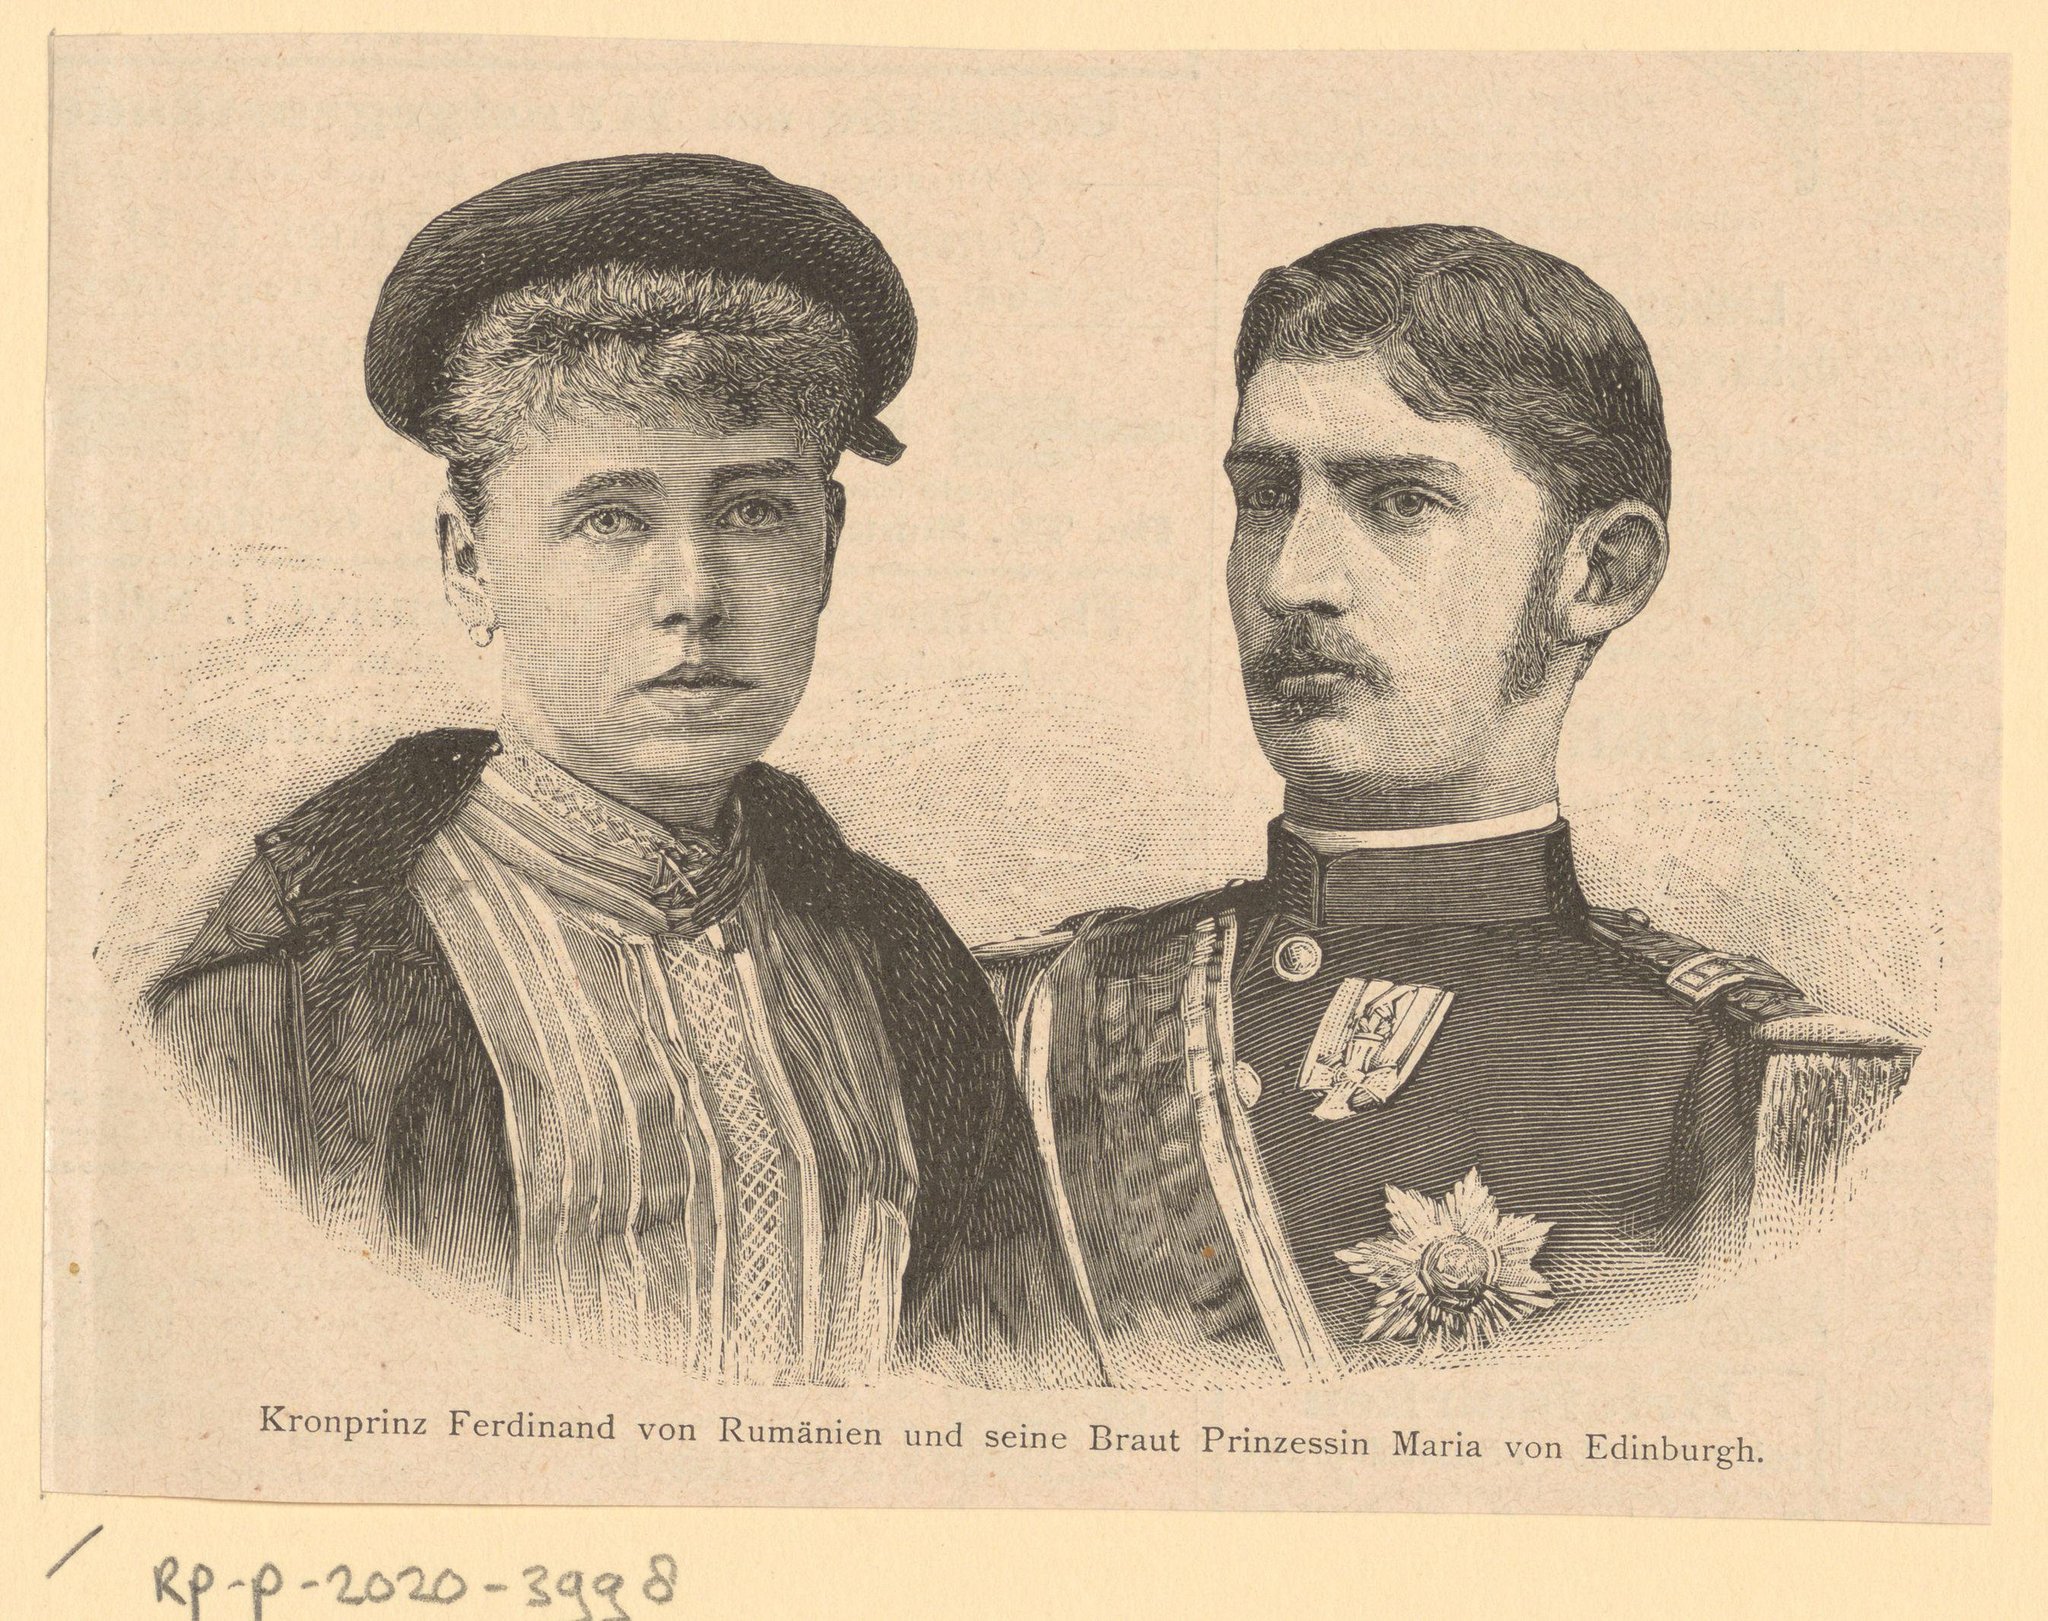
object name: print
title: Portret van Marie van Edinburgh en Ferdinand I van Roemenië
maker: Anonymous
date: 1892-1894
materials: paper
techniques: letterpress printing, engraving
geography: germany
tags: historical person in a double portrait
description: Prent komt uit een onbekend tijdschrift.